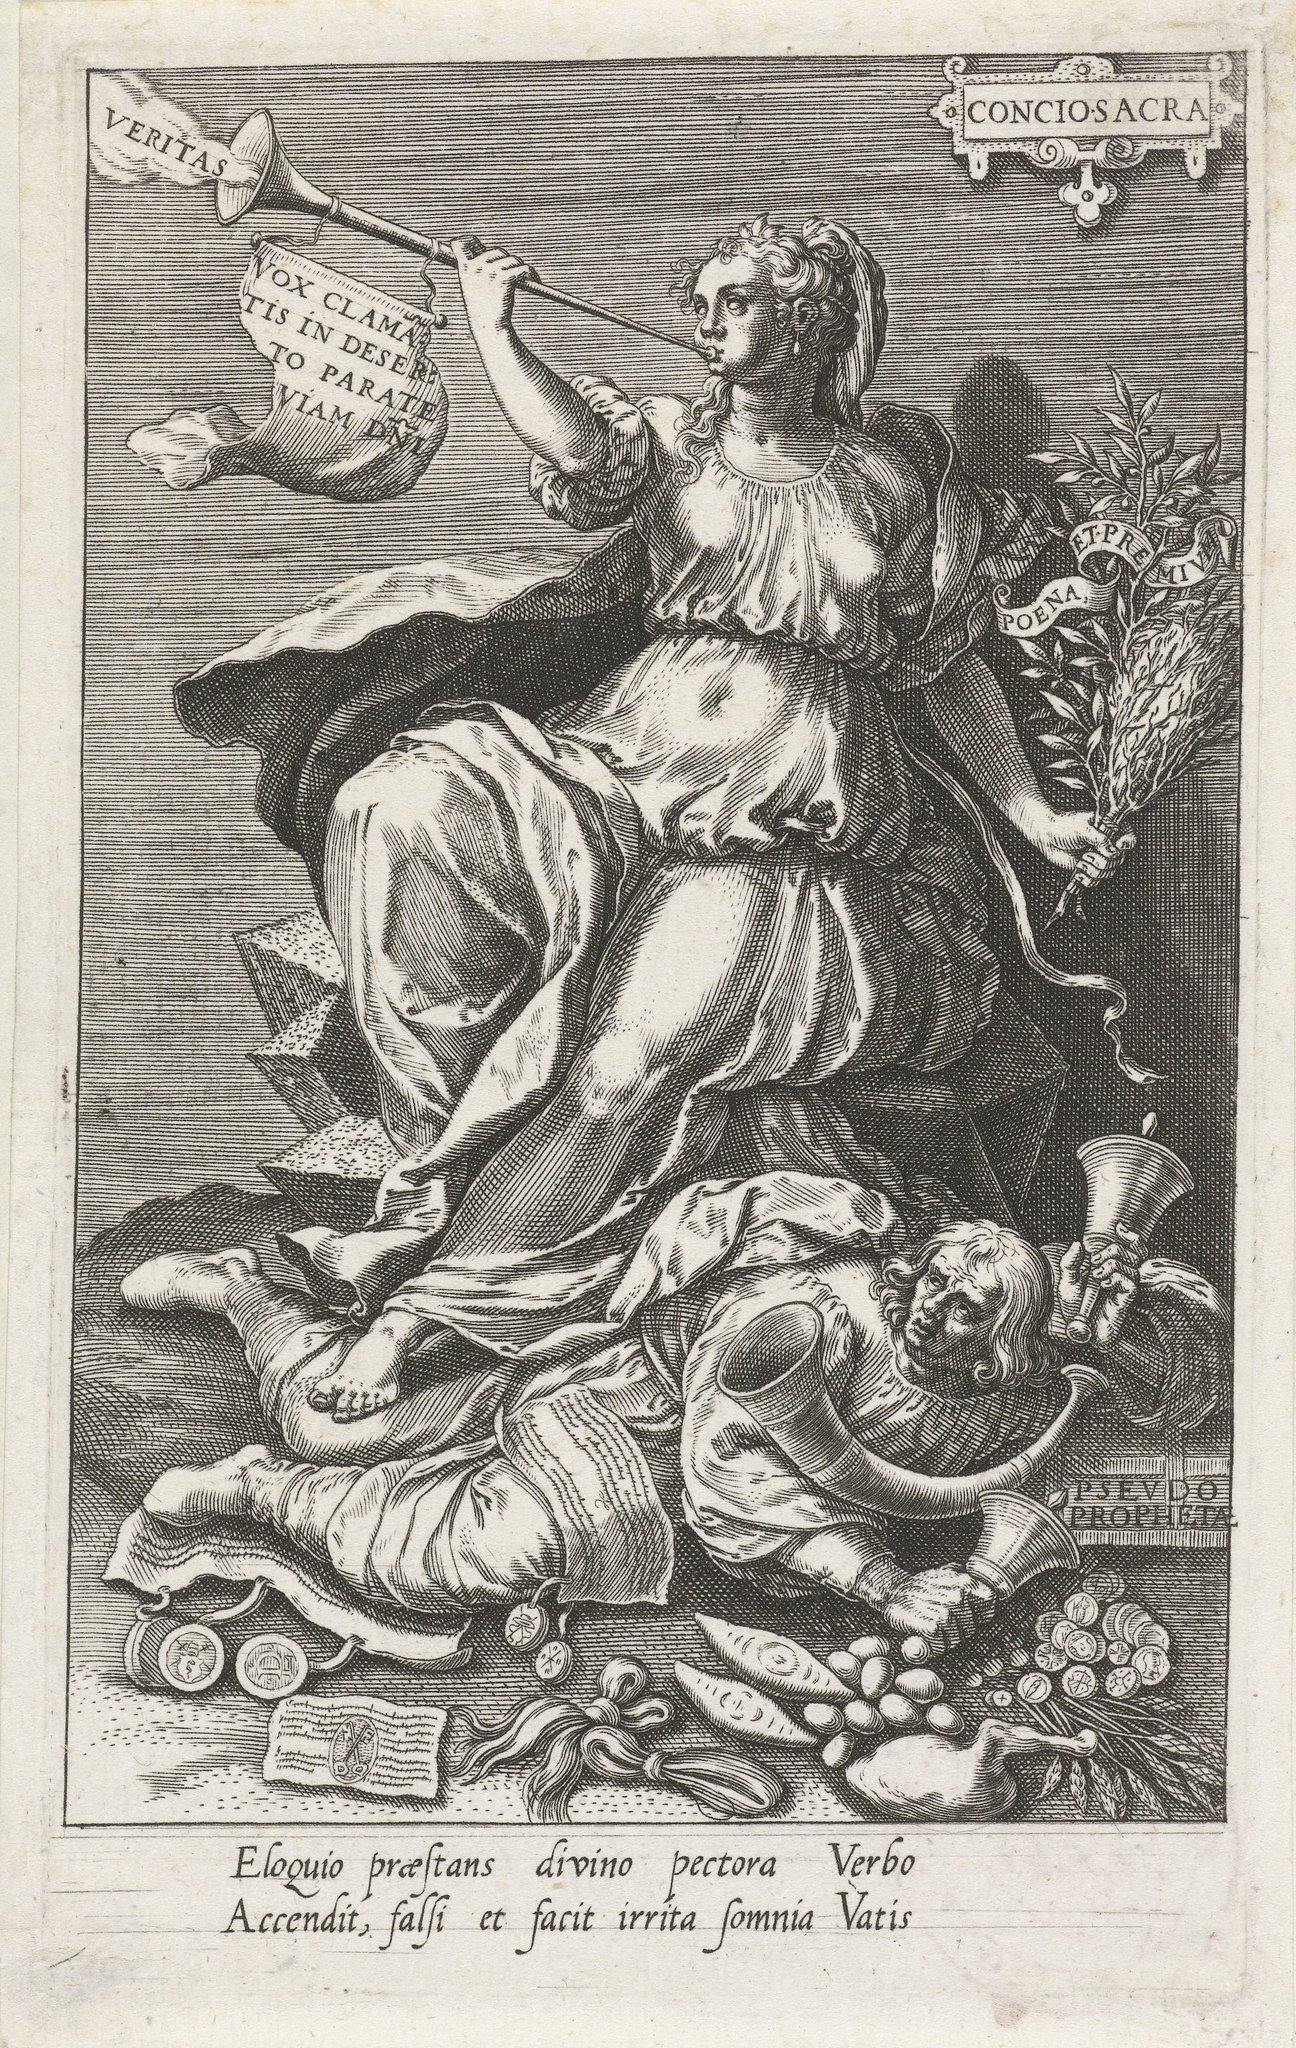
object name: print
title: Conciosacra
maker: johann sadeler (i)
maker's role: print maker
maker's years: 1550-1600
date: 1579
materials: paper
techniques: engraving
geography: antwerp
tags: false church personified, relics (and reliquaries), truth; 'verità' (ripa), conscience; 'coscienza' (ripa), indulgence ~ confession, punishment; 'castigo', 'pena', 'punitione' (ripa), rewarding goodness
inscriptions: collector's mark: Lugt 240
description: De personificatie Geweten (Conciosacra). Ze blaast op de trompet van Waarheid (Veritas). In haar linkerhand de roede van straf en een olijftak van beloning (Poena et primium). Ze vertrapt de personificatie van Valse Profeten (Pseudo prophetae), een man met aflaten, relieken, een hoorn en twee handbellen.